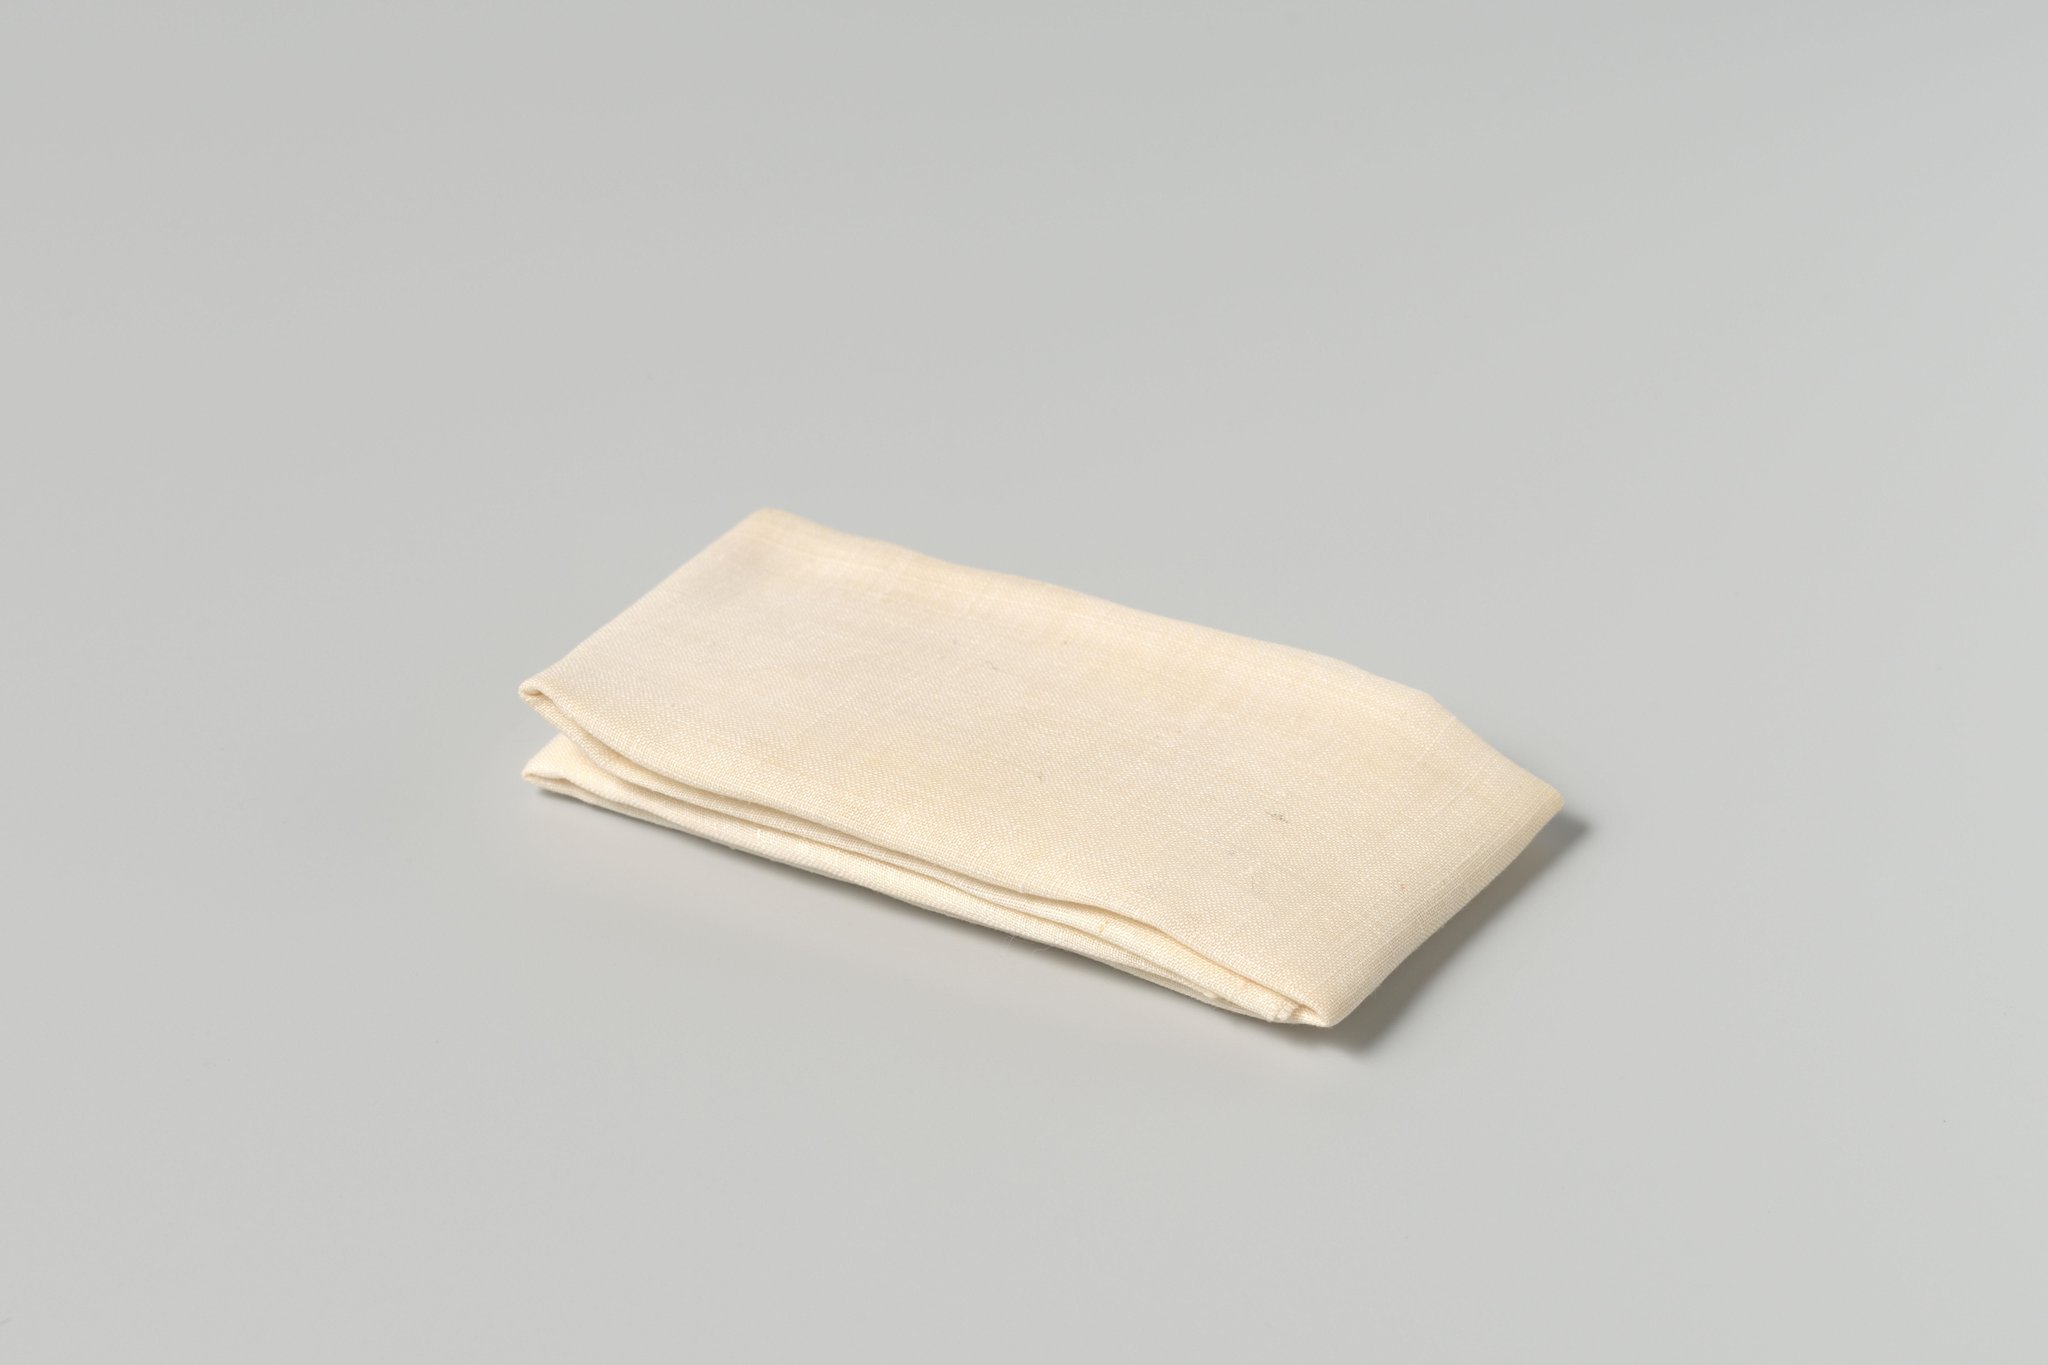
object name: beddenlaken, laken object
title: Laken of lap van linnen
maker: Anonymous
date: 1675-1899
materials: linen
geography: netherlands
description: Lap, op het formaat van een laken, van fijn linnen, omgezoomd.